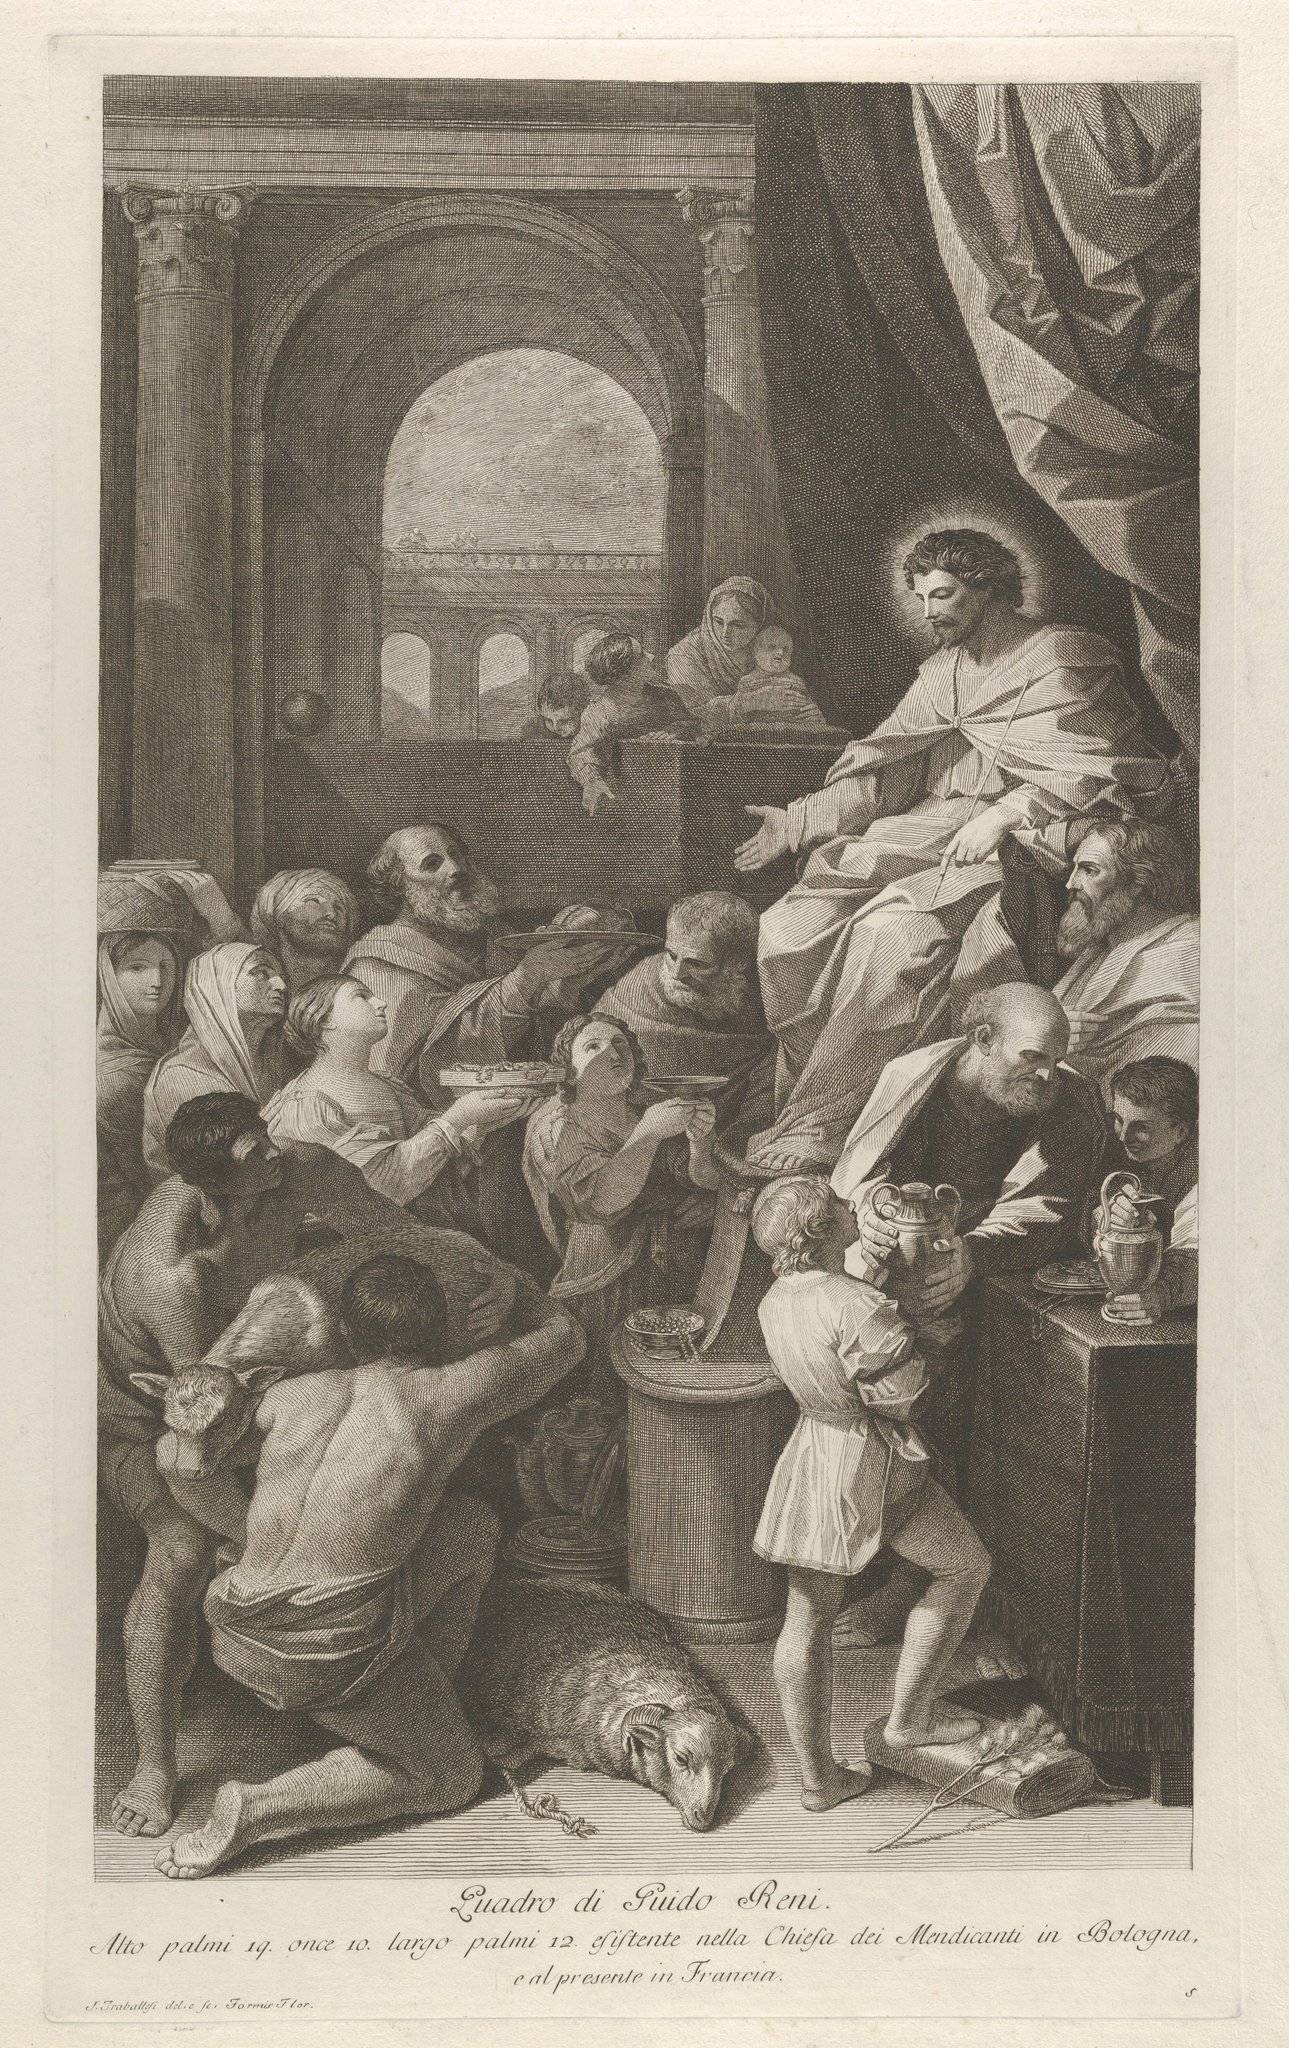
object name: print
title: Saint Job seated at right receiving the gifts of the people, archway at left, after Reni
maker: giuliano traballesi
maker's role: artist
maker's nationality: italian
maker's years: 1727-1812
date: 1760-1800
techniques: engraving, etching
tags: animals,men,women,saints